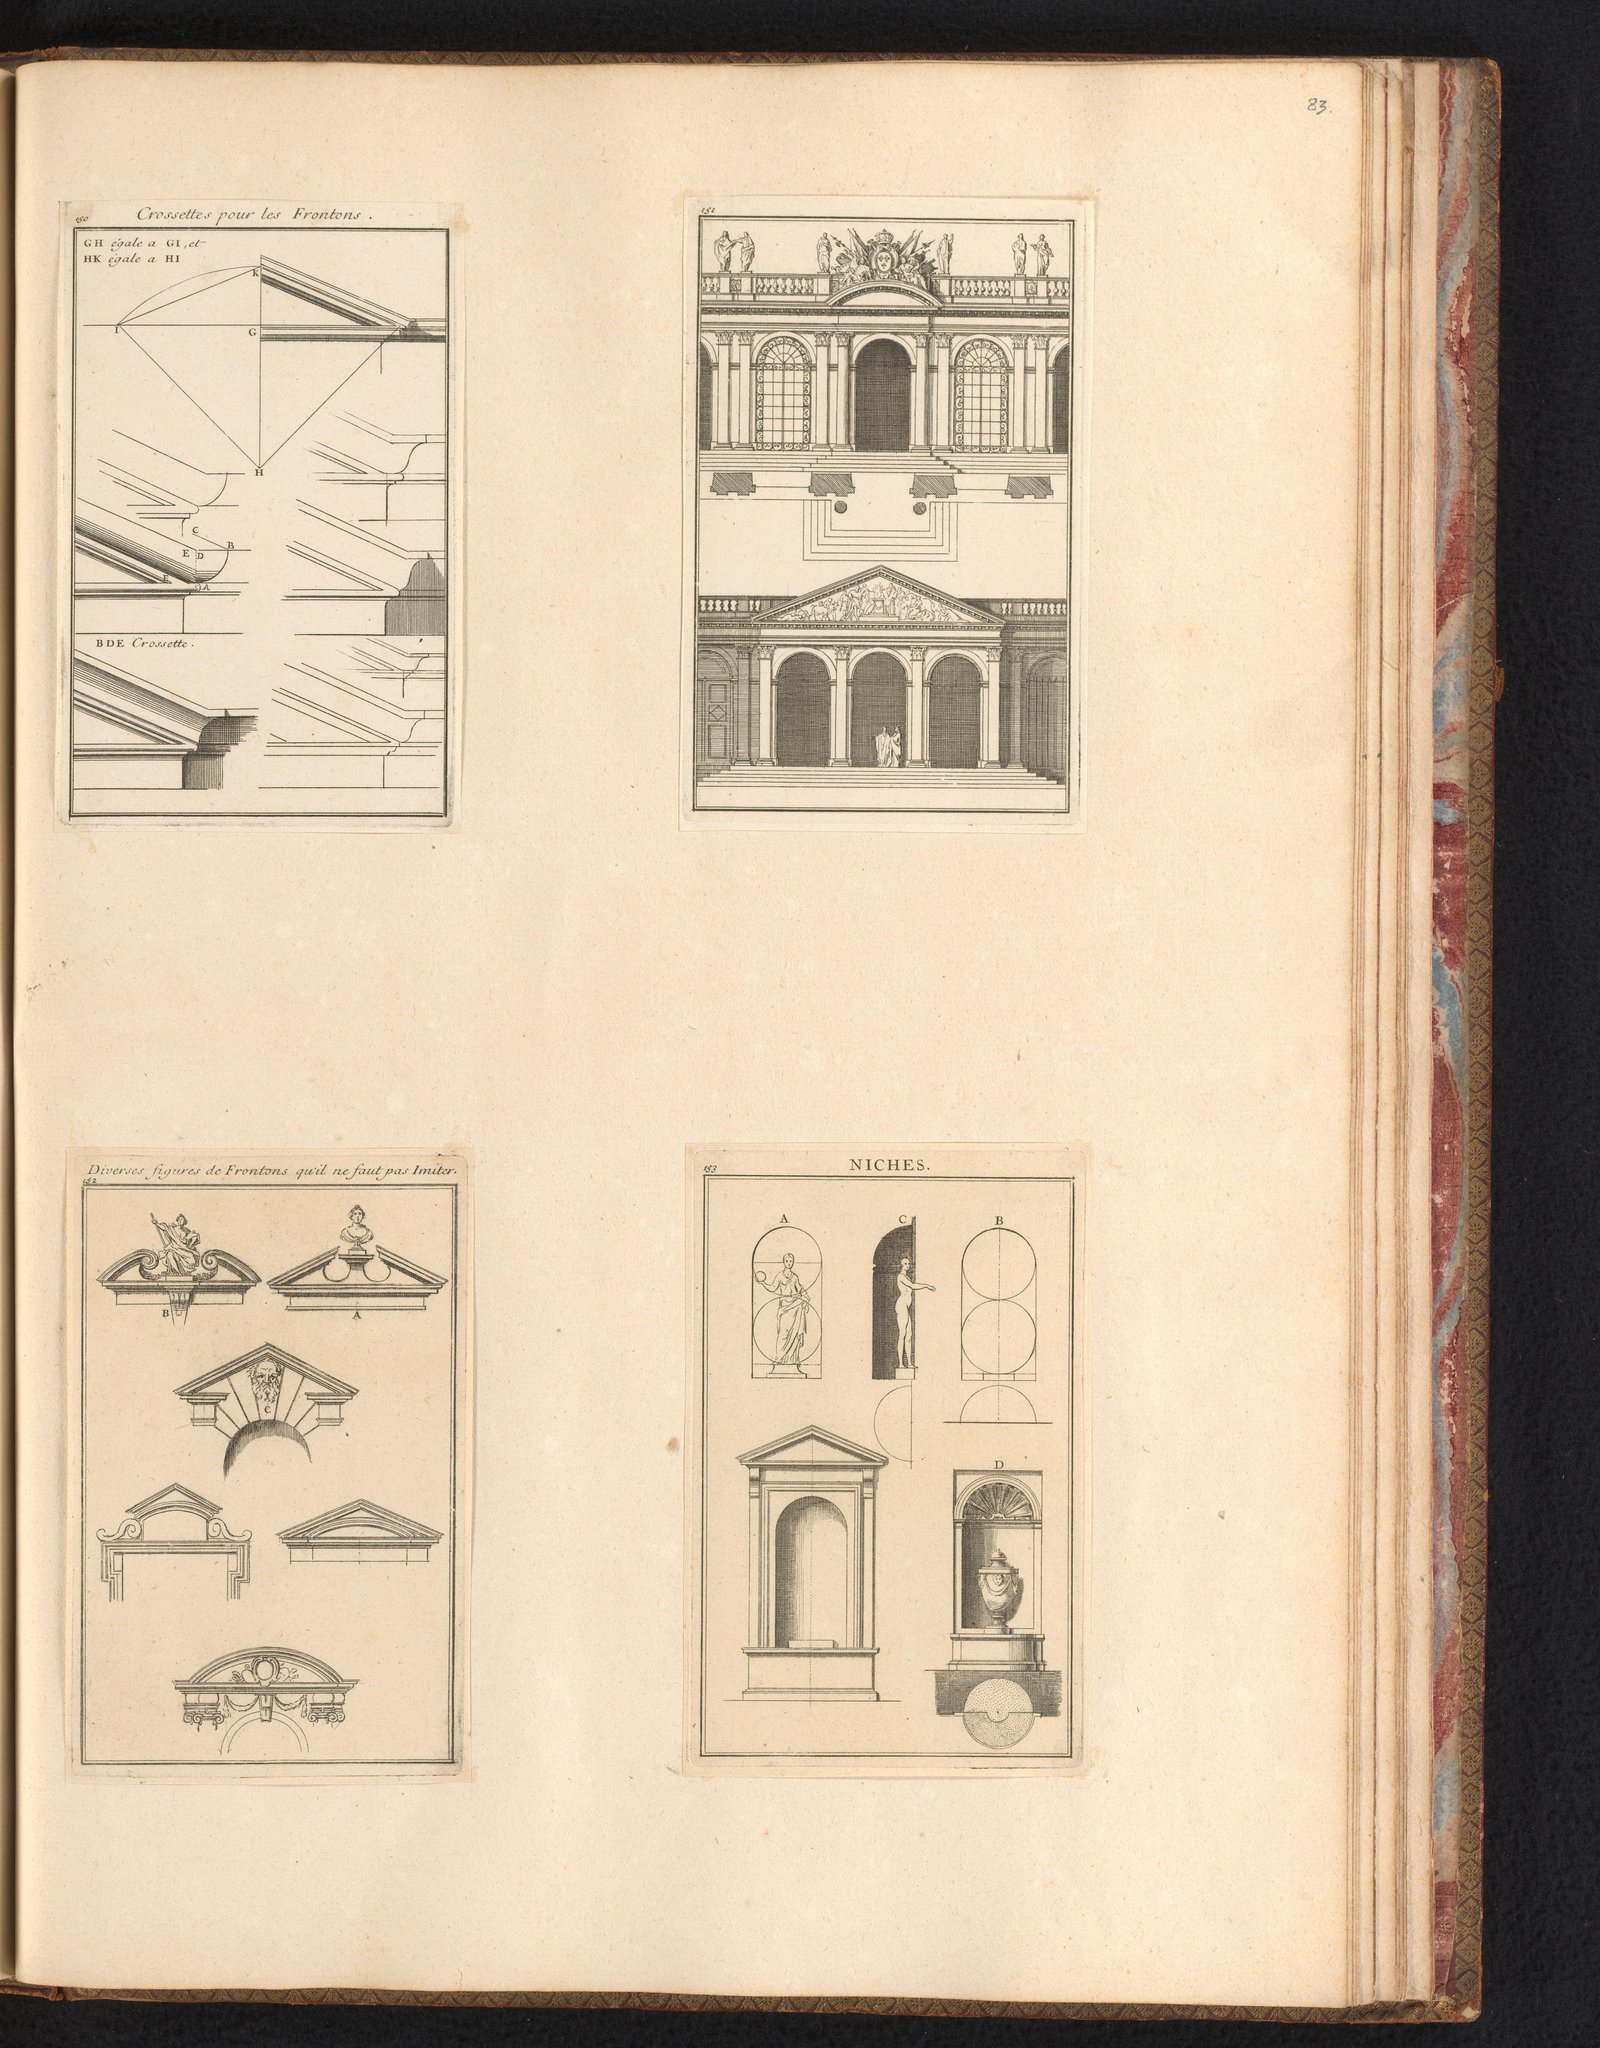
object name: print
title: Klassieke architecturale elementen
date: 1714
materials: paper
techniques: etching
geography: paris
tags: other architectural details (with name), architectural detail, door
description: Details van architectuur waaronder timpanen of frontons en nissen. Prenten genummerd 150 t/m 153. Deze vier prenten maken deel uit van een album.